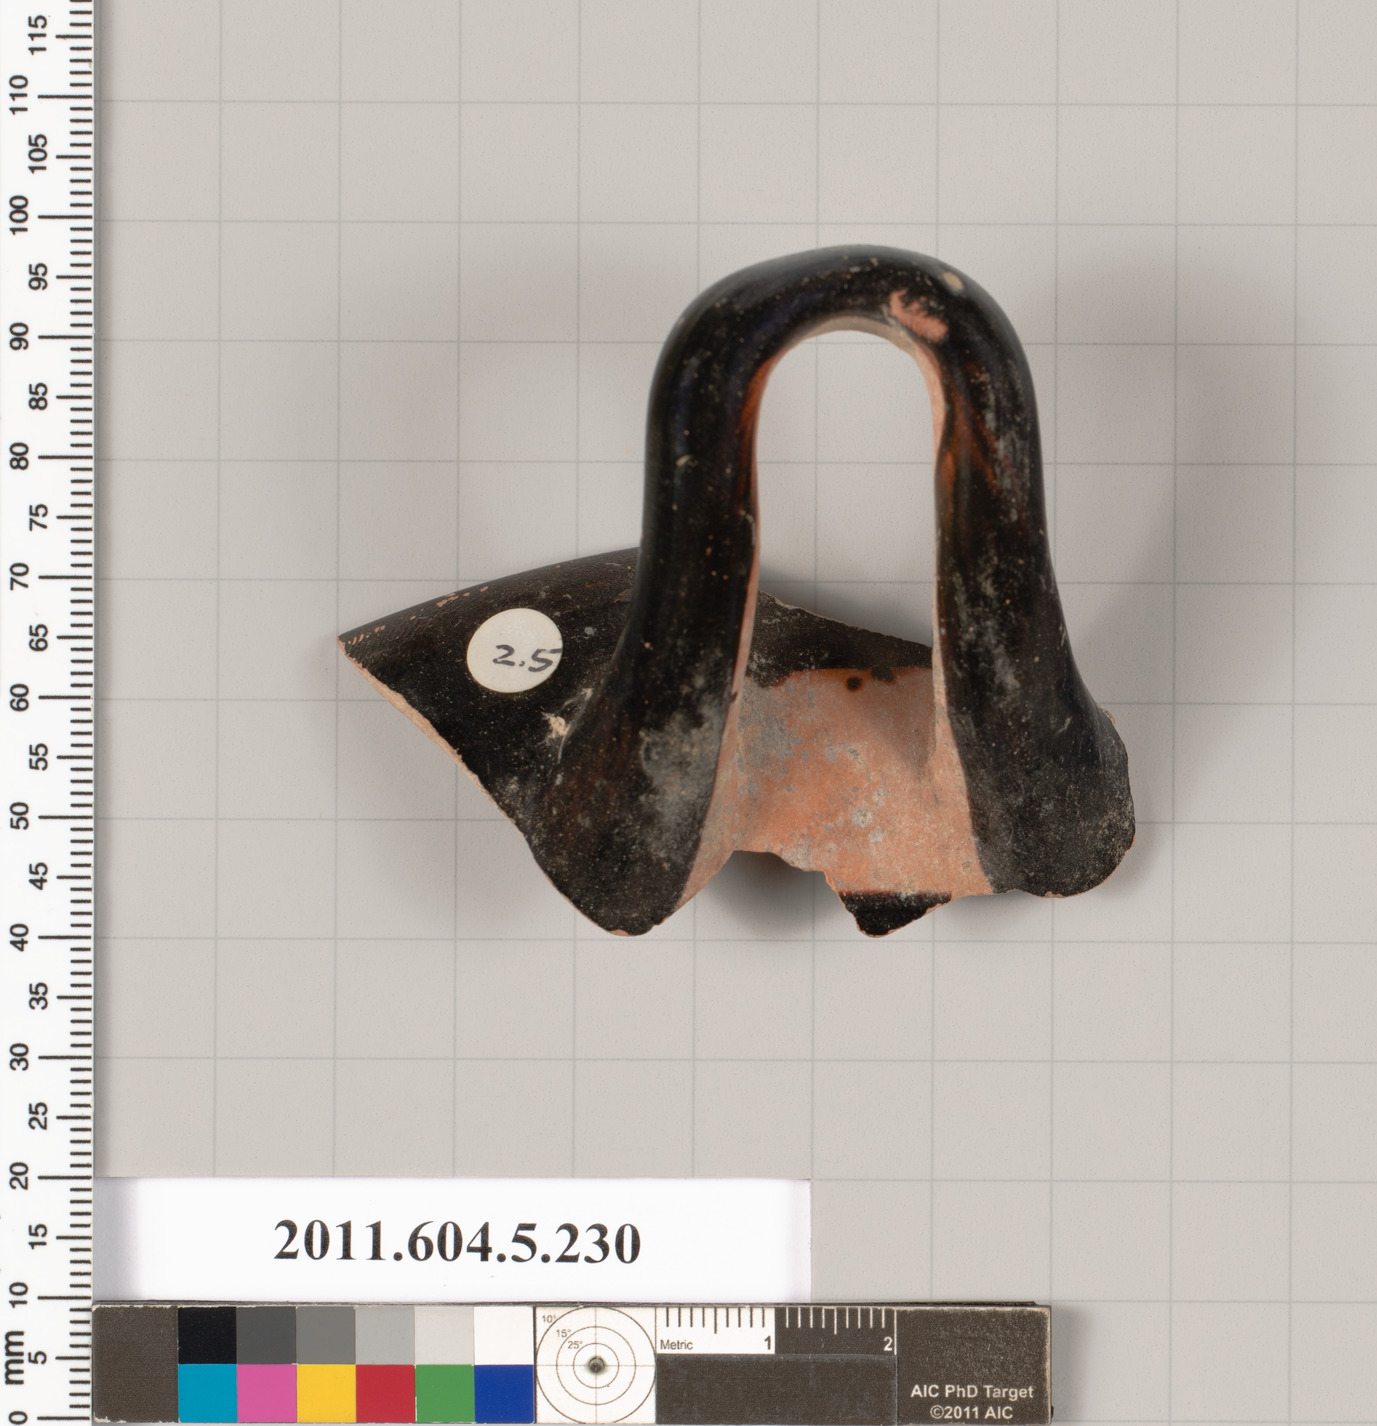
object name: kylix fragment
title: Terracotta rim fragment of a kylix (drinking cup)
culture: greek, attic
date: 600-401 BCE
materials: terracotta